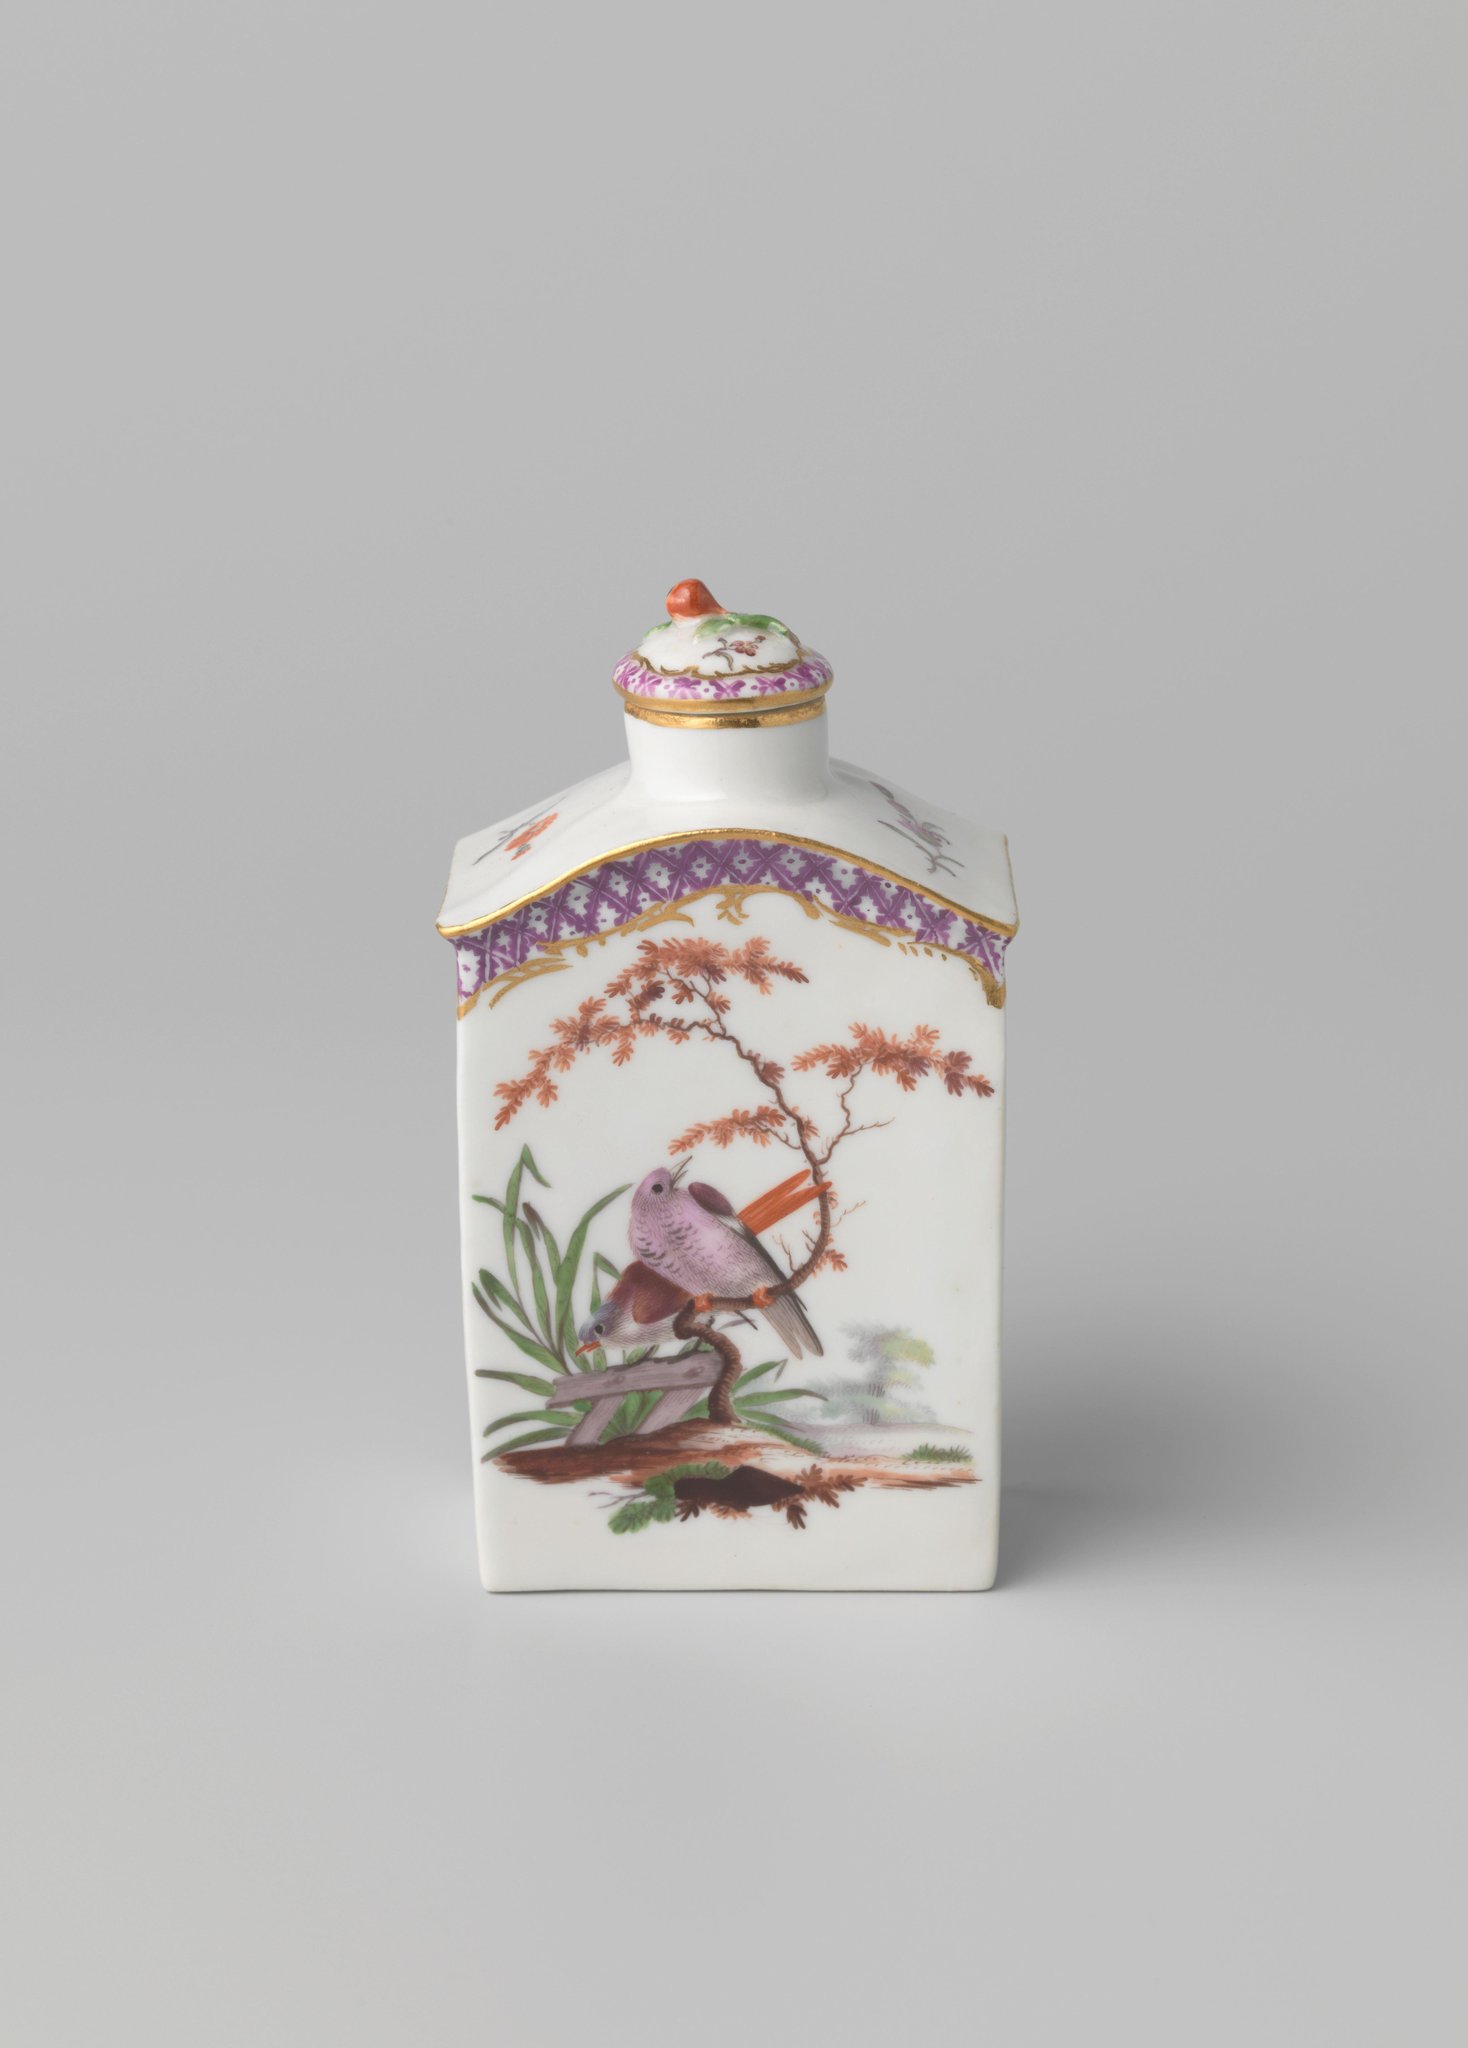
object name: lid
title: Cover of a tea caddy with birds in a landscape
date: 1765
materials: glaze, gold, paint, porcelain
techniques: firing, forming, gilding, turning, vitrification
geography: ansbach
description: Deksel van een theebus van porselein, beschilderd op het glazuur in emailkleuren en goud. Versierd met strooibloemen en een band met servetwerk; dekselknop in de vorm van een fruittak (peer).